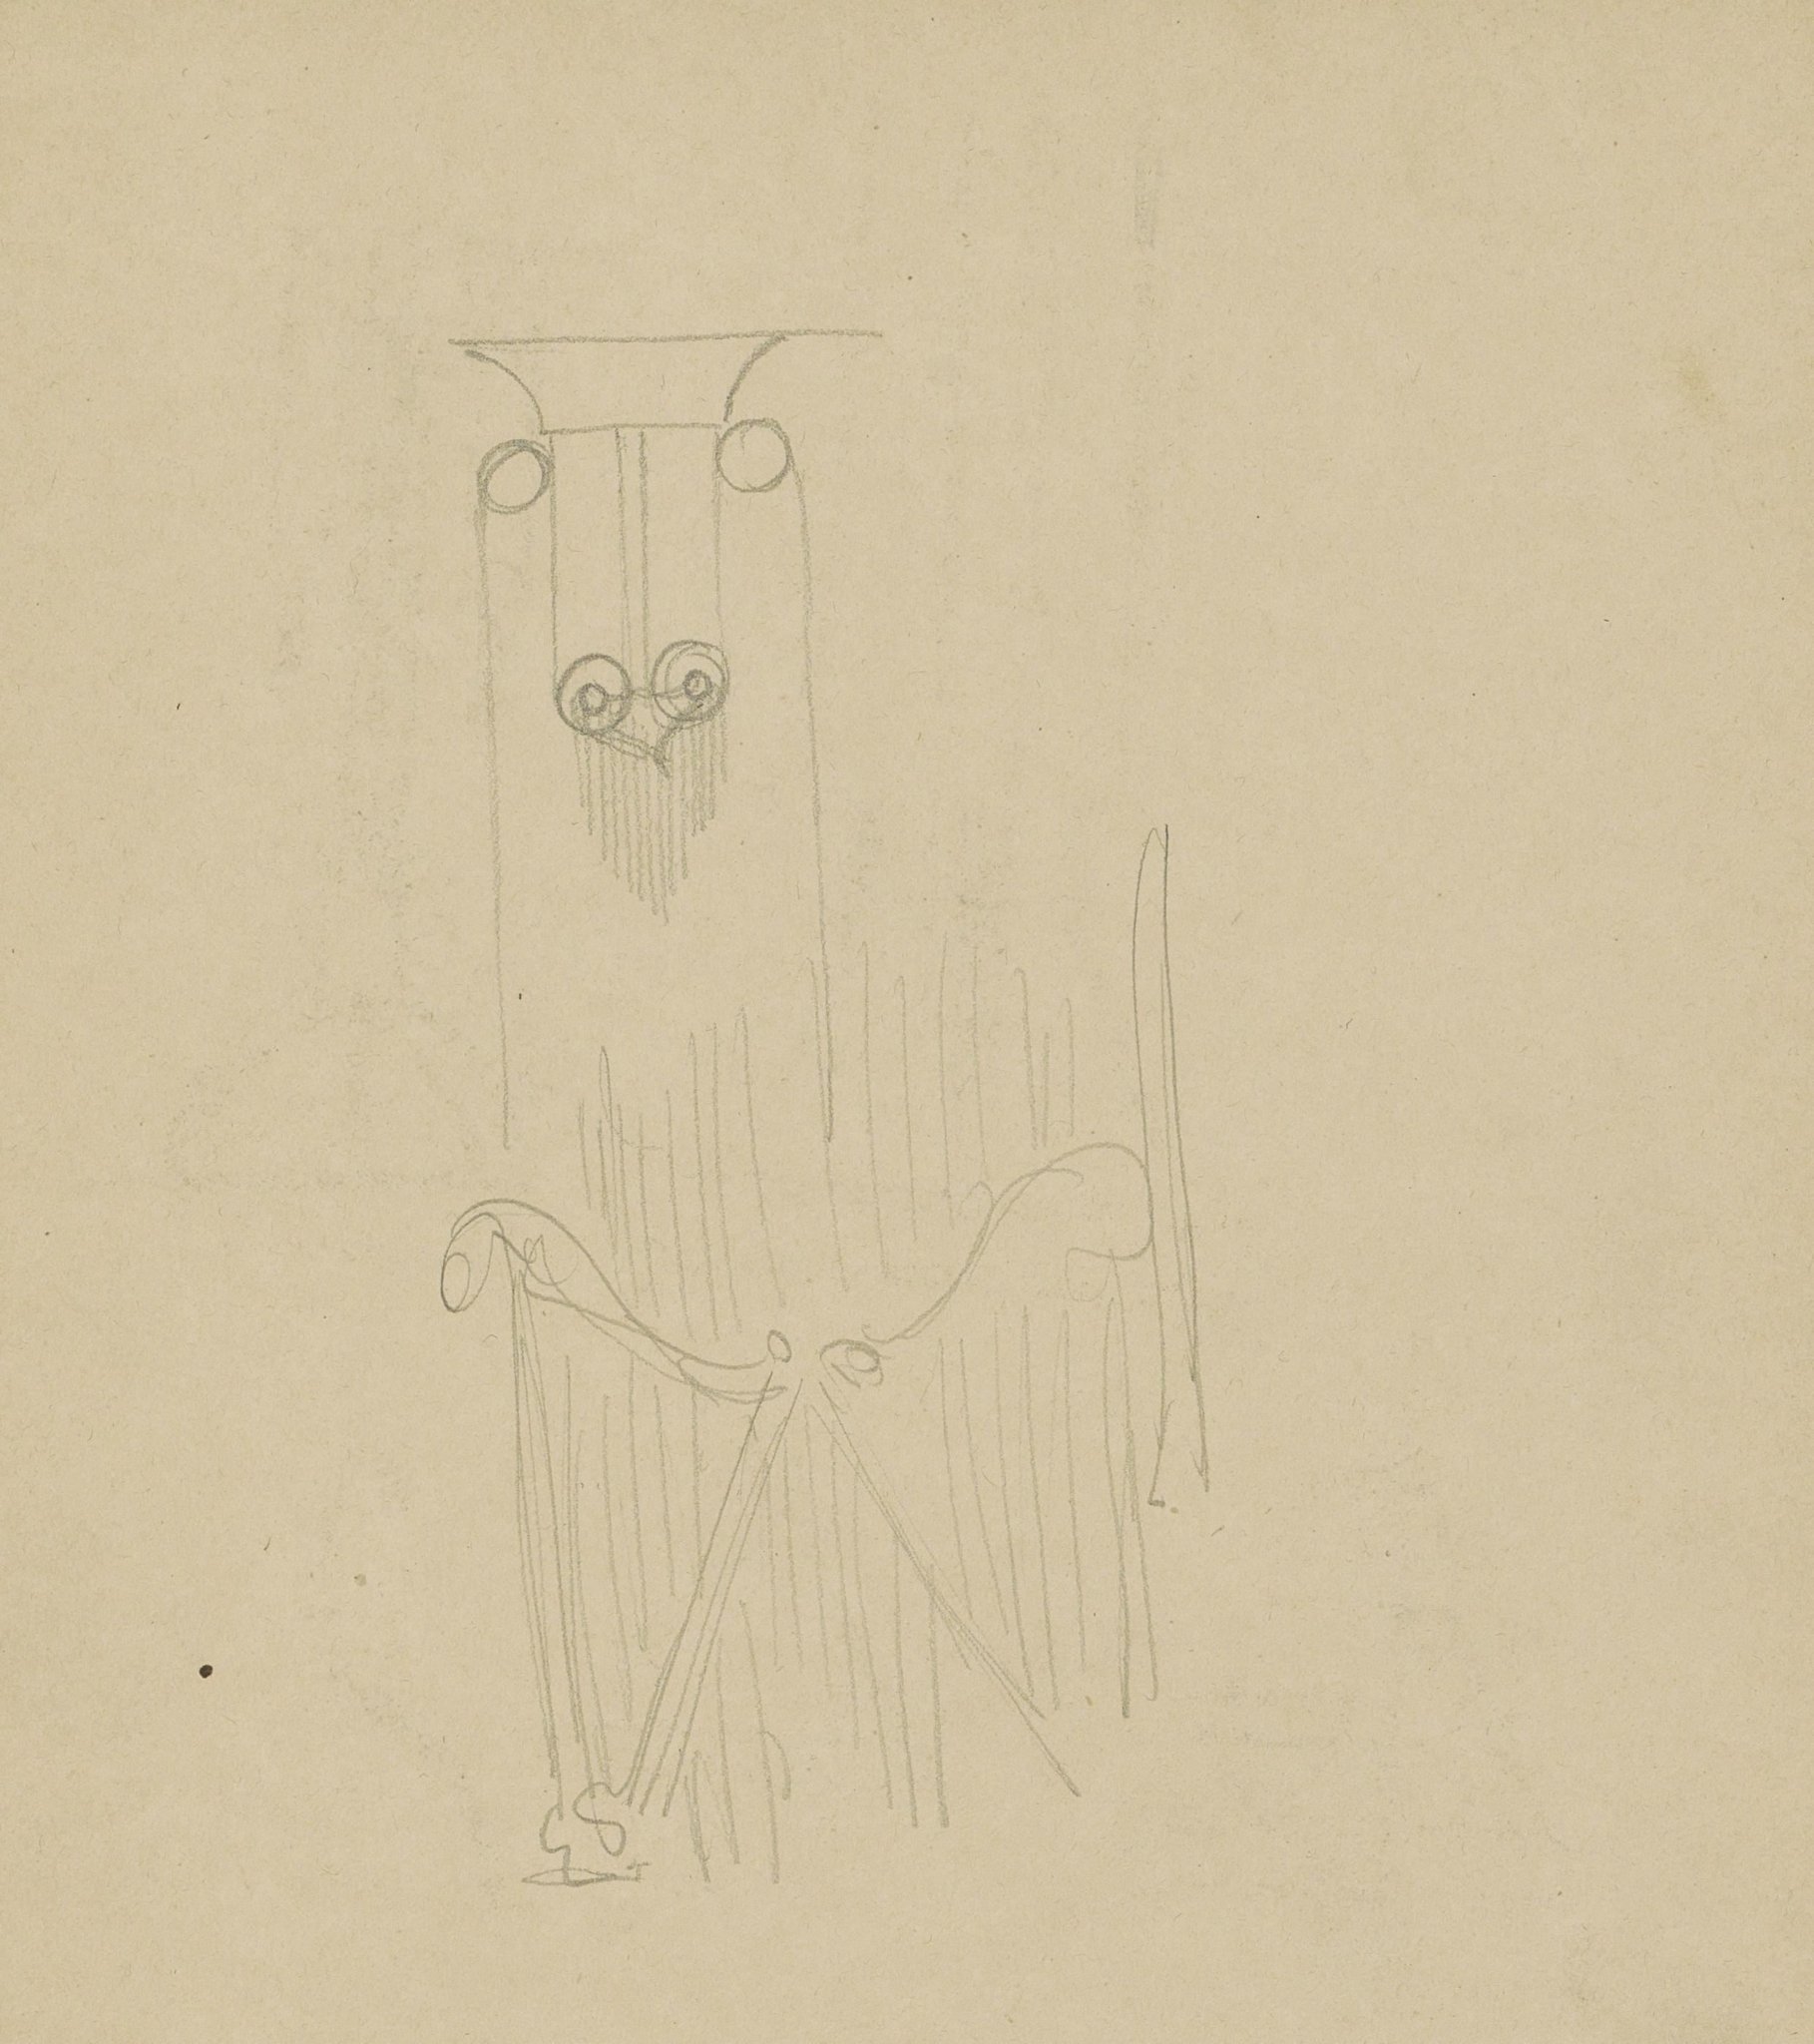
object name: sketchbook leaf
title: Ontwerp voor een lamp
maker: carel adolph lion cachet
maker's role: draughtsman, print maker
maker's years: 1864-1945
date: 1905-1906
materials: paper, pencil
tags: lighting; lamps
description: Blad 4 verso uit een schetsboek met 30 bladen.